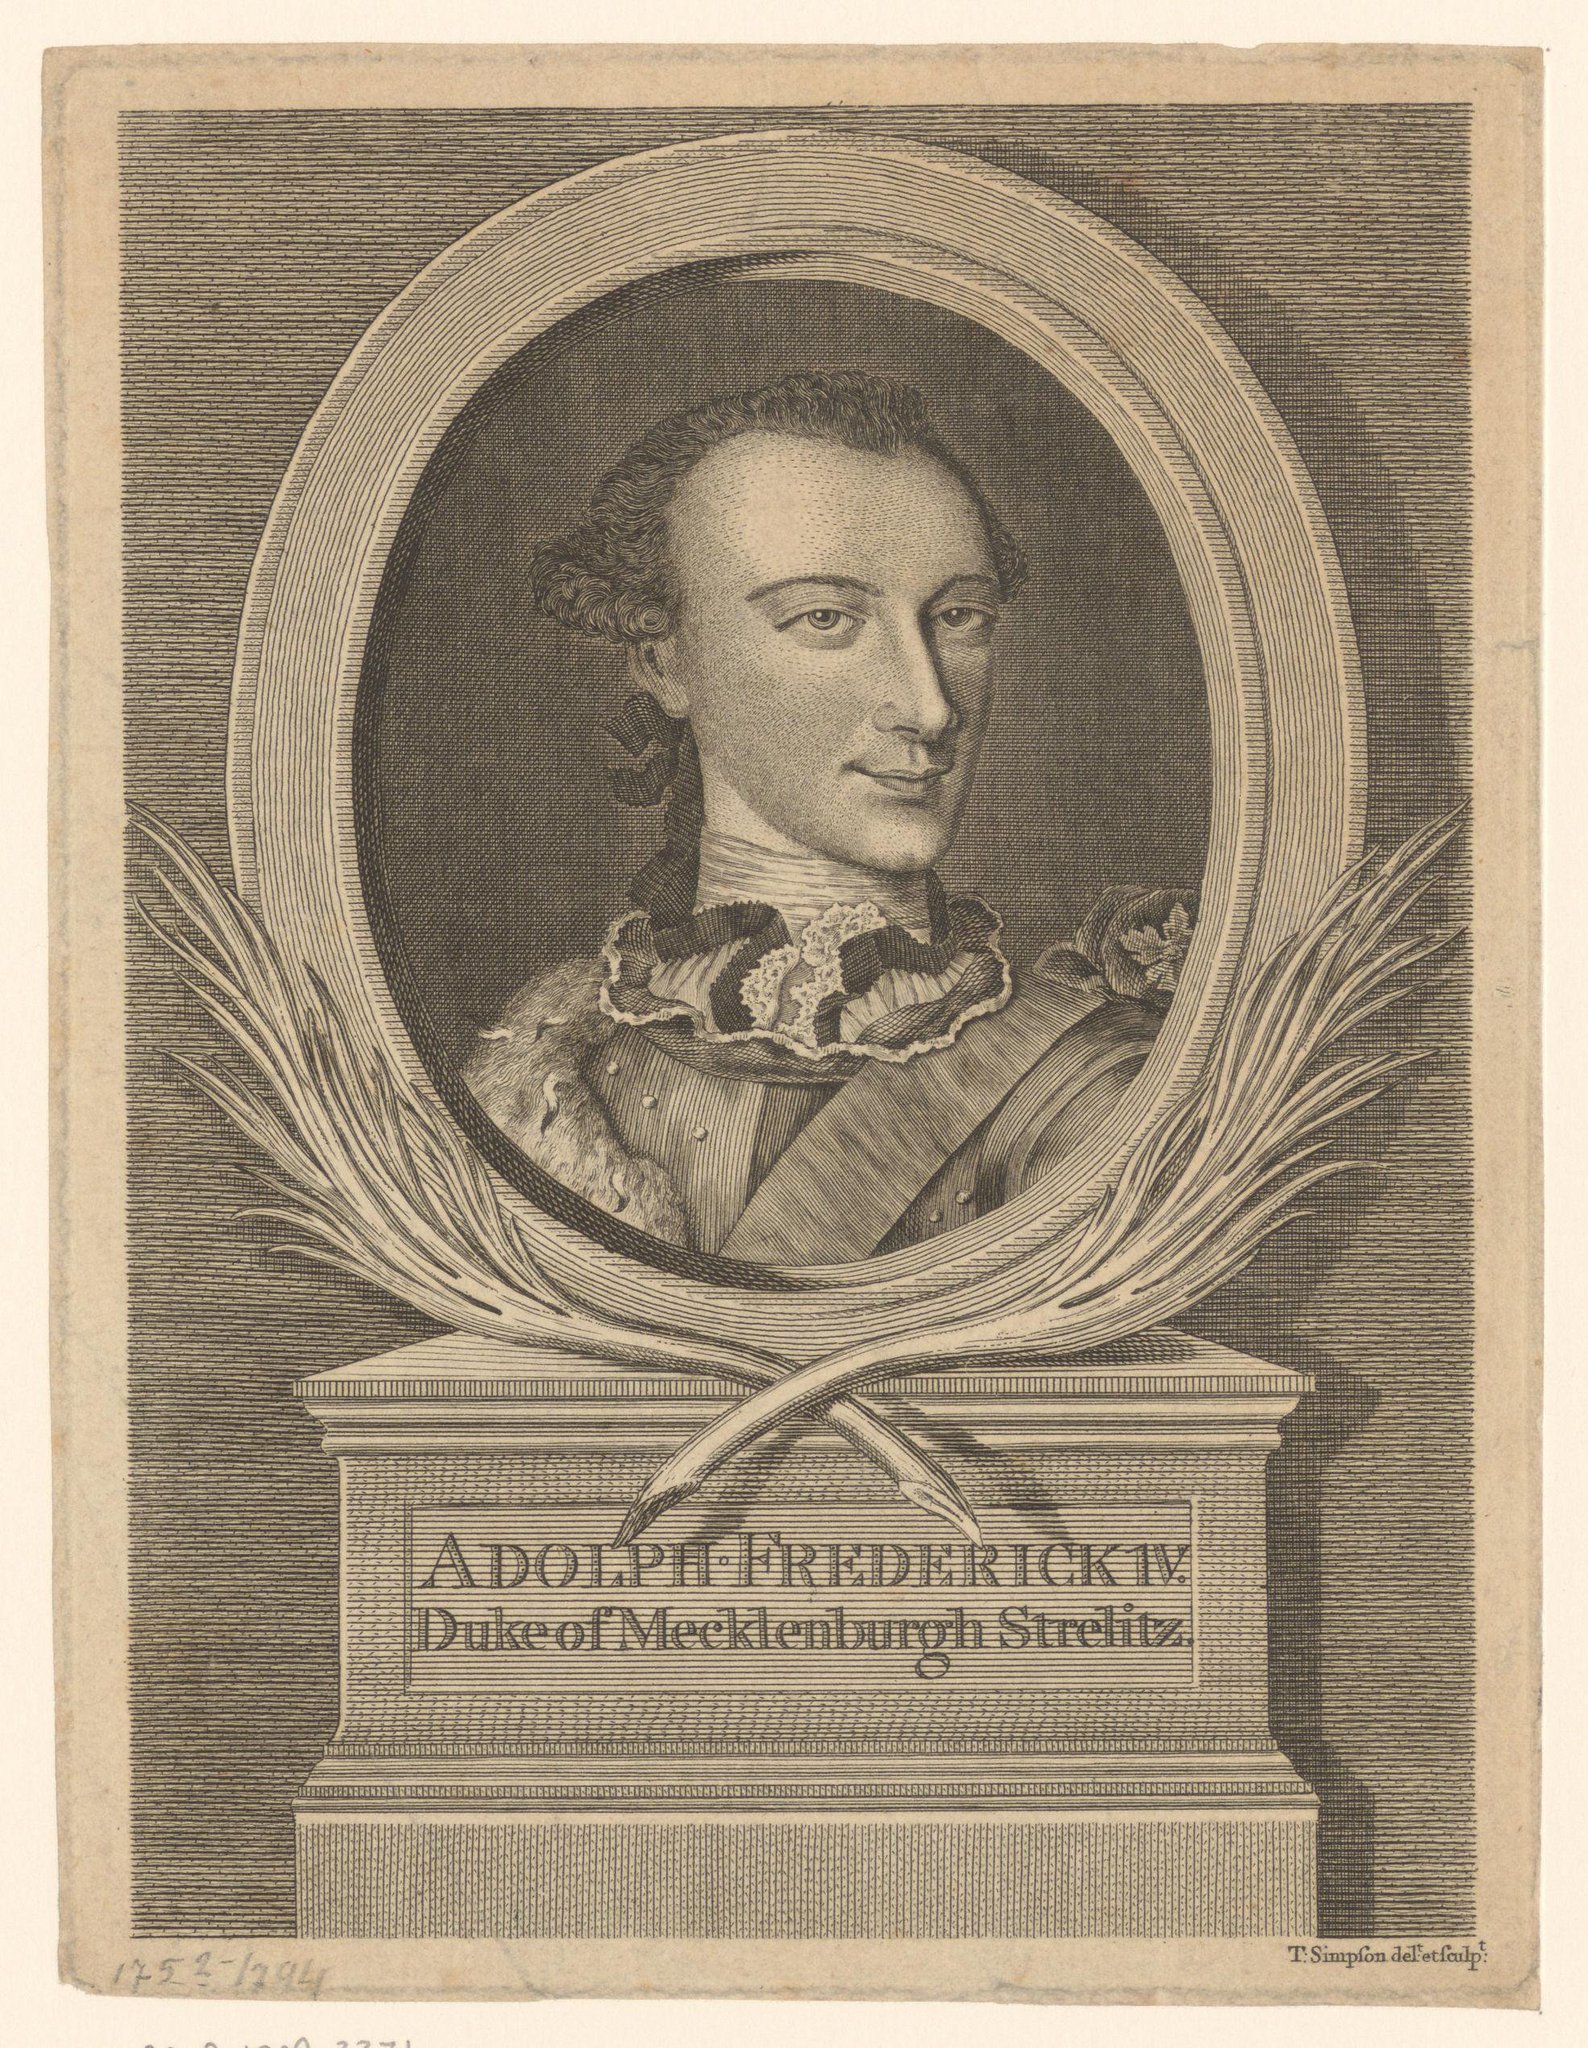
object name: print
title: Adolph Frederick IV, Duke of Mecklenburgh Strelitz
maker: thomas simpson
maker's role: publisher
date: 1765-1794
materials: paper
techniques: engraving, etching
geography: london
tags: historical persons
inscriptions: collector's mark: Lugt 2228